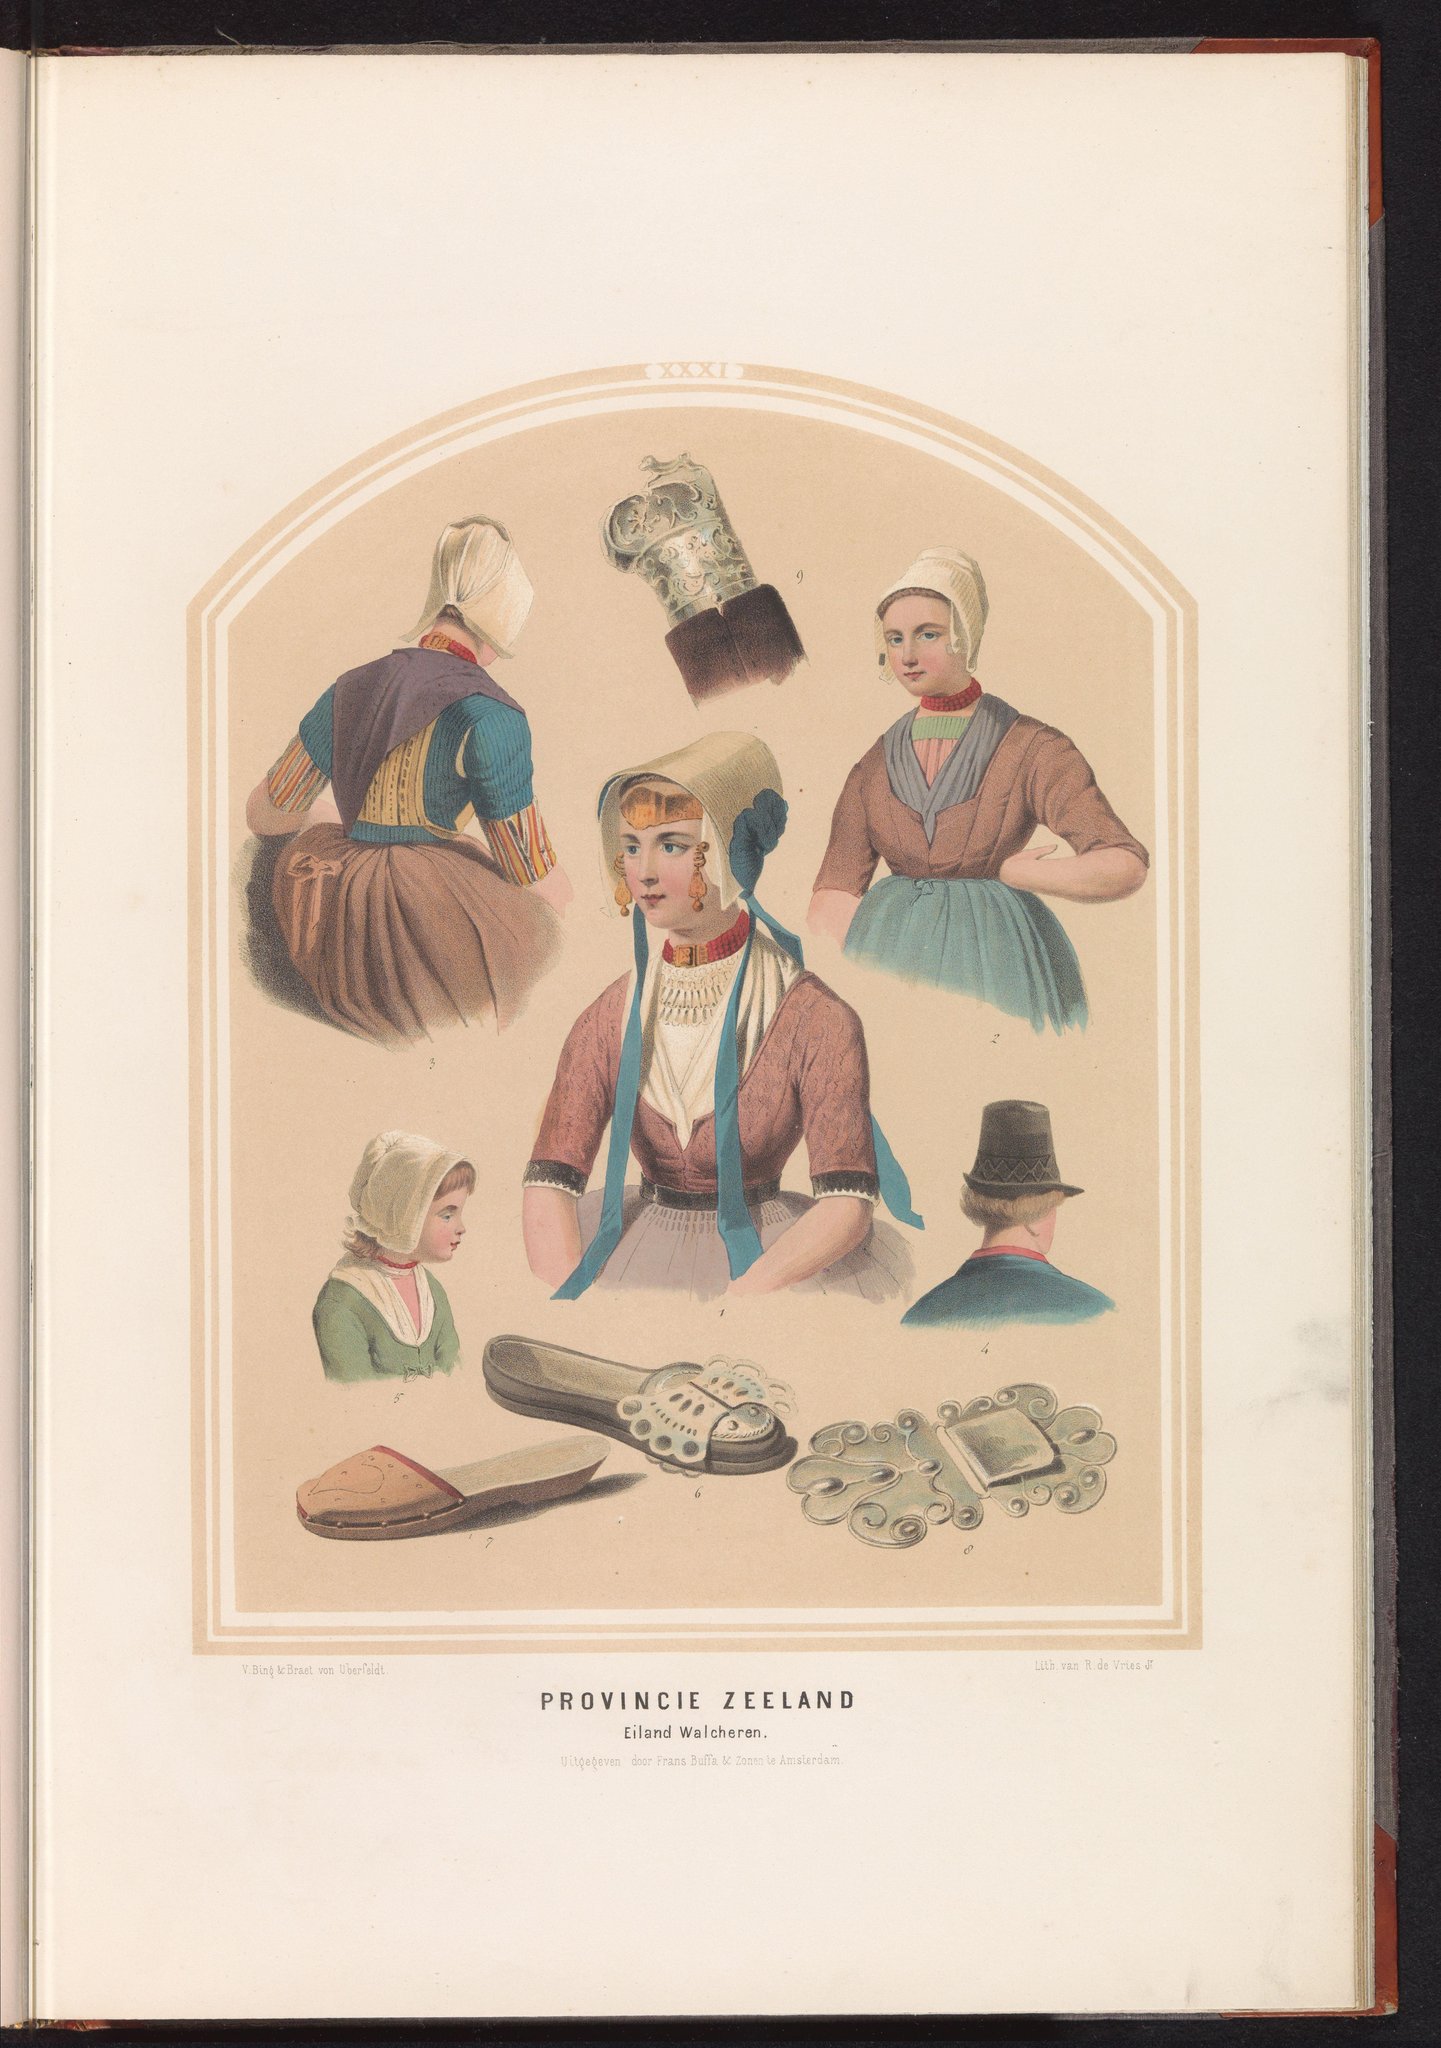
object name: print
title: Provincie Zeeland. Eiland Walcheren / XXXI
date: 1857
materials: paper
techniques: hand coloring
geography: netherlands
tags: folk costume, regional costume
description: Klederdracht van het eiland Walcheren in de provincie Zeeland. Verschillende afzonderlijke studies. Illustratie in een boek uit 1857 met 56 platen van Nederlandse klederdrachten.